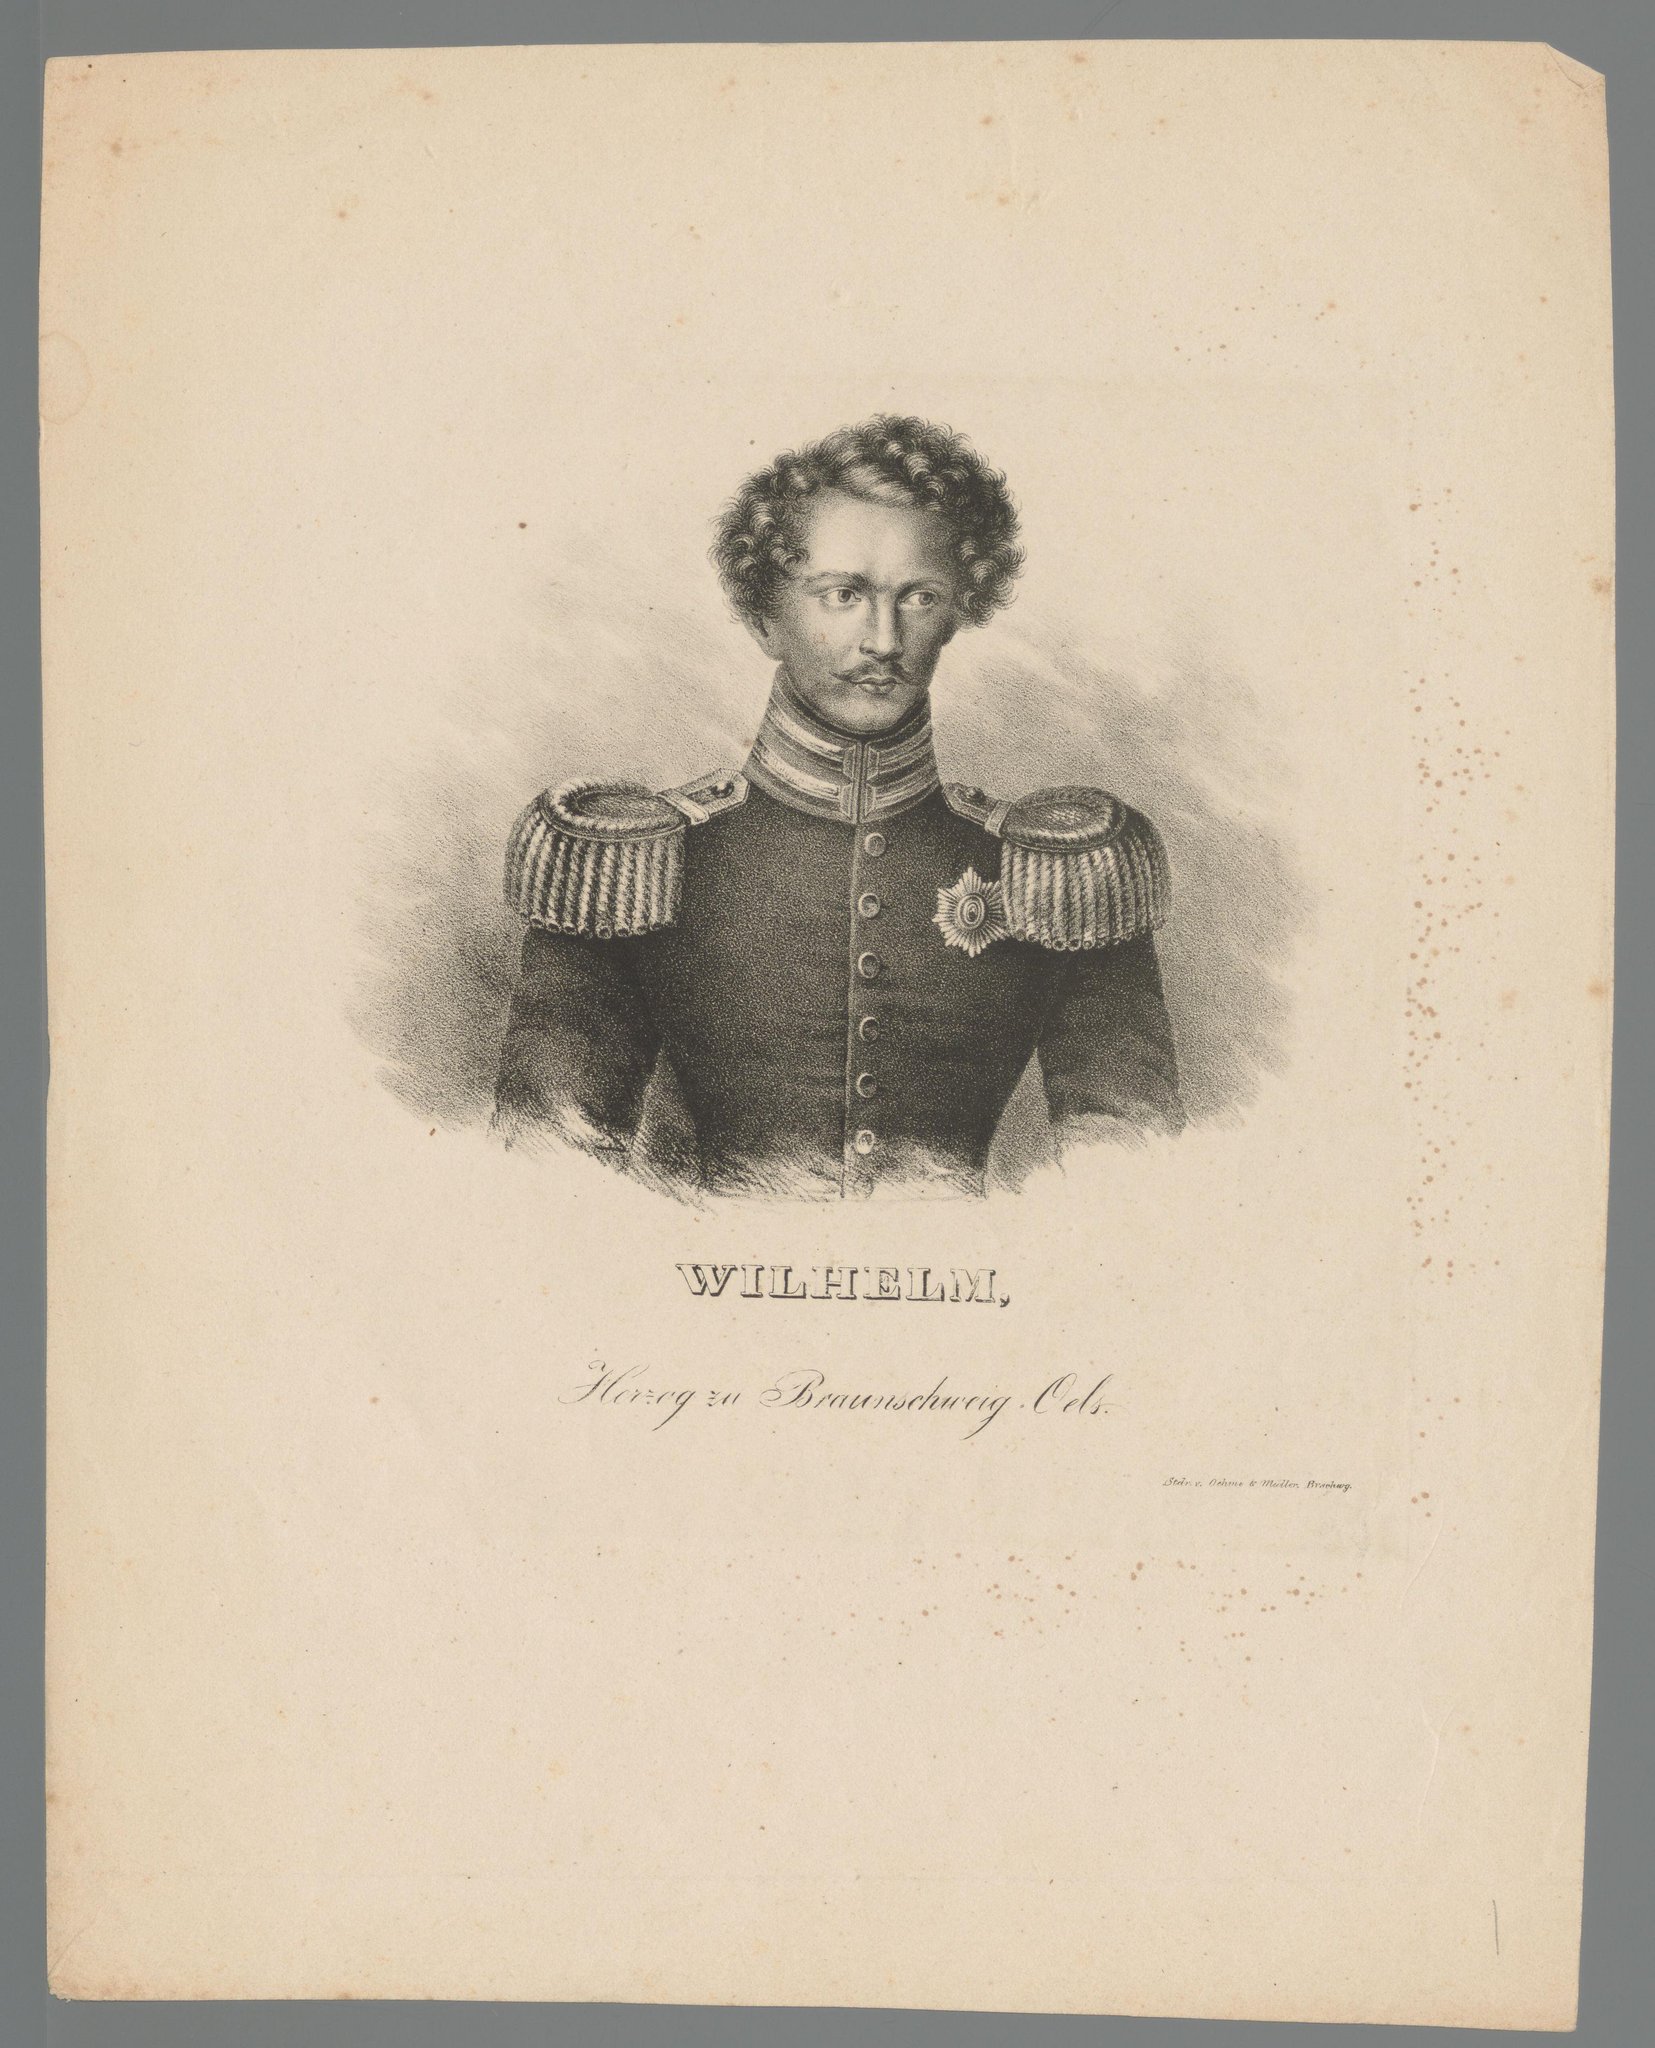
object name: print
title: Portret van Wilhelm August von Braunschweig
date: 1825-1850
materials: paper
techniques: lithograph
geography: braunschweig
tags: willem van brunswijk, moustache, adult man, historical persons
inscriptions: collector's mark: Lugt 2228